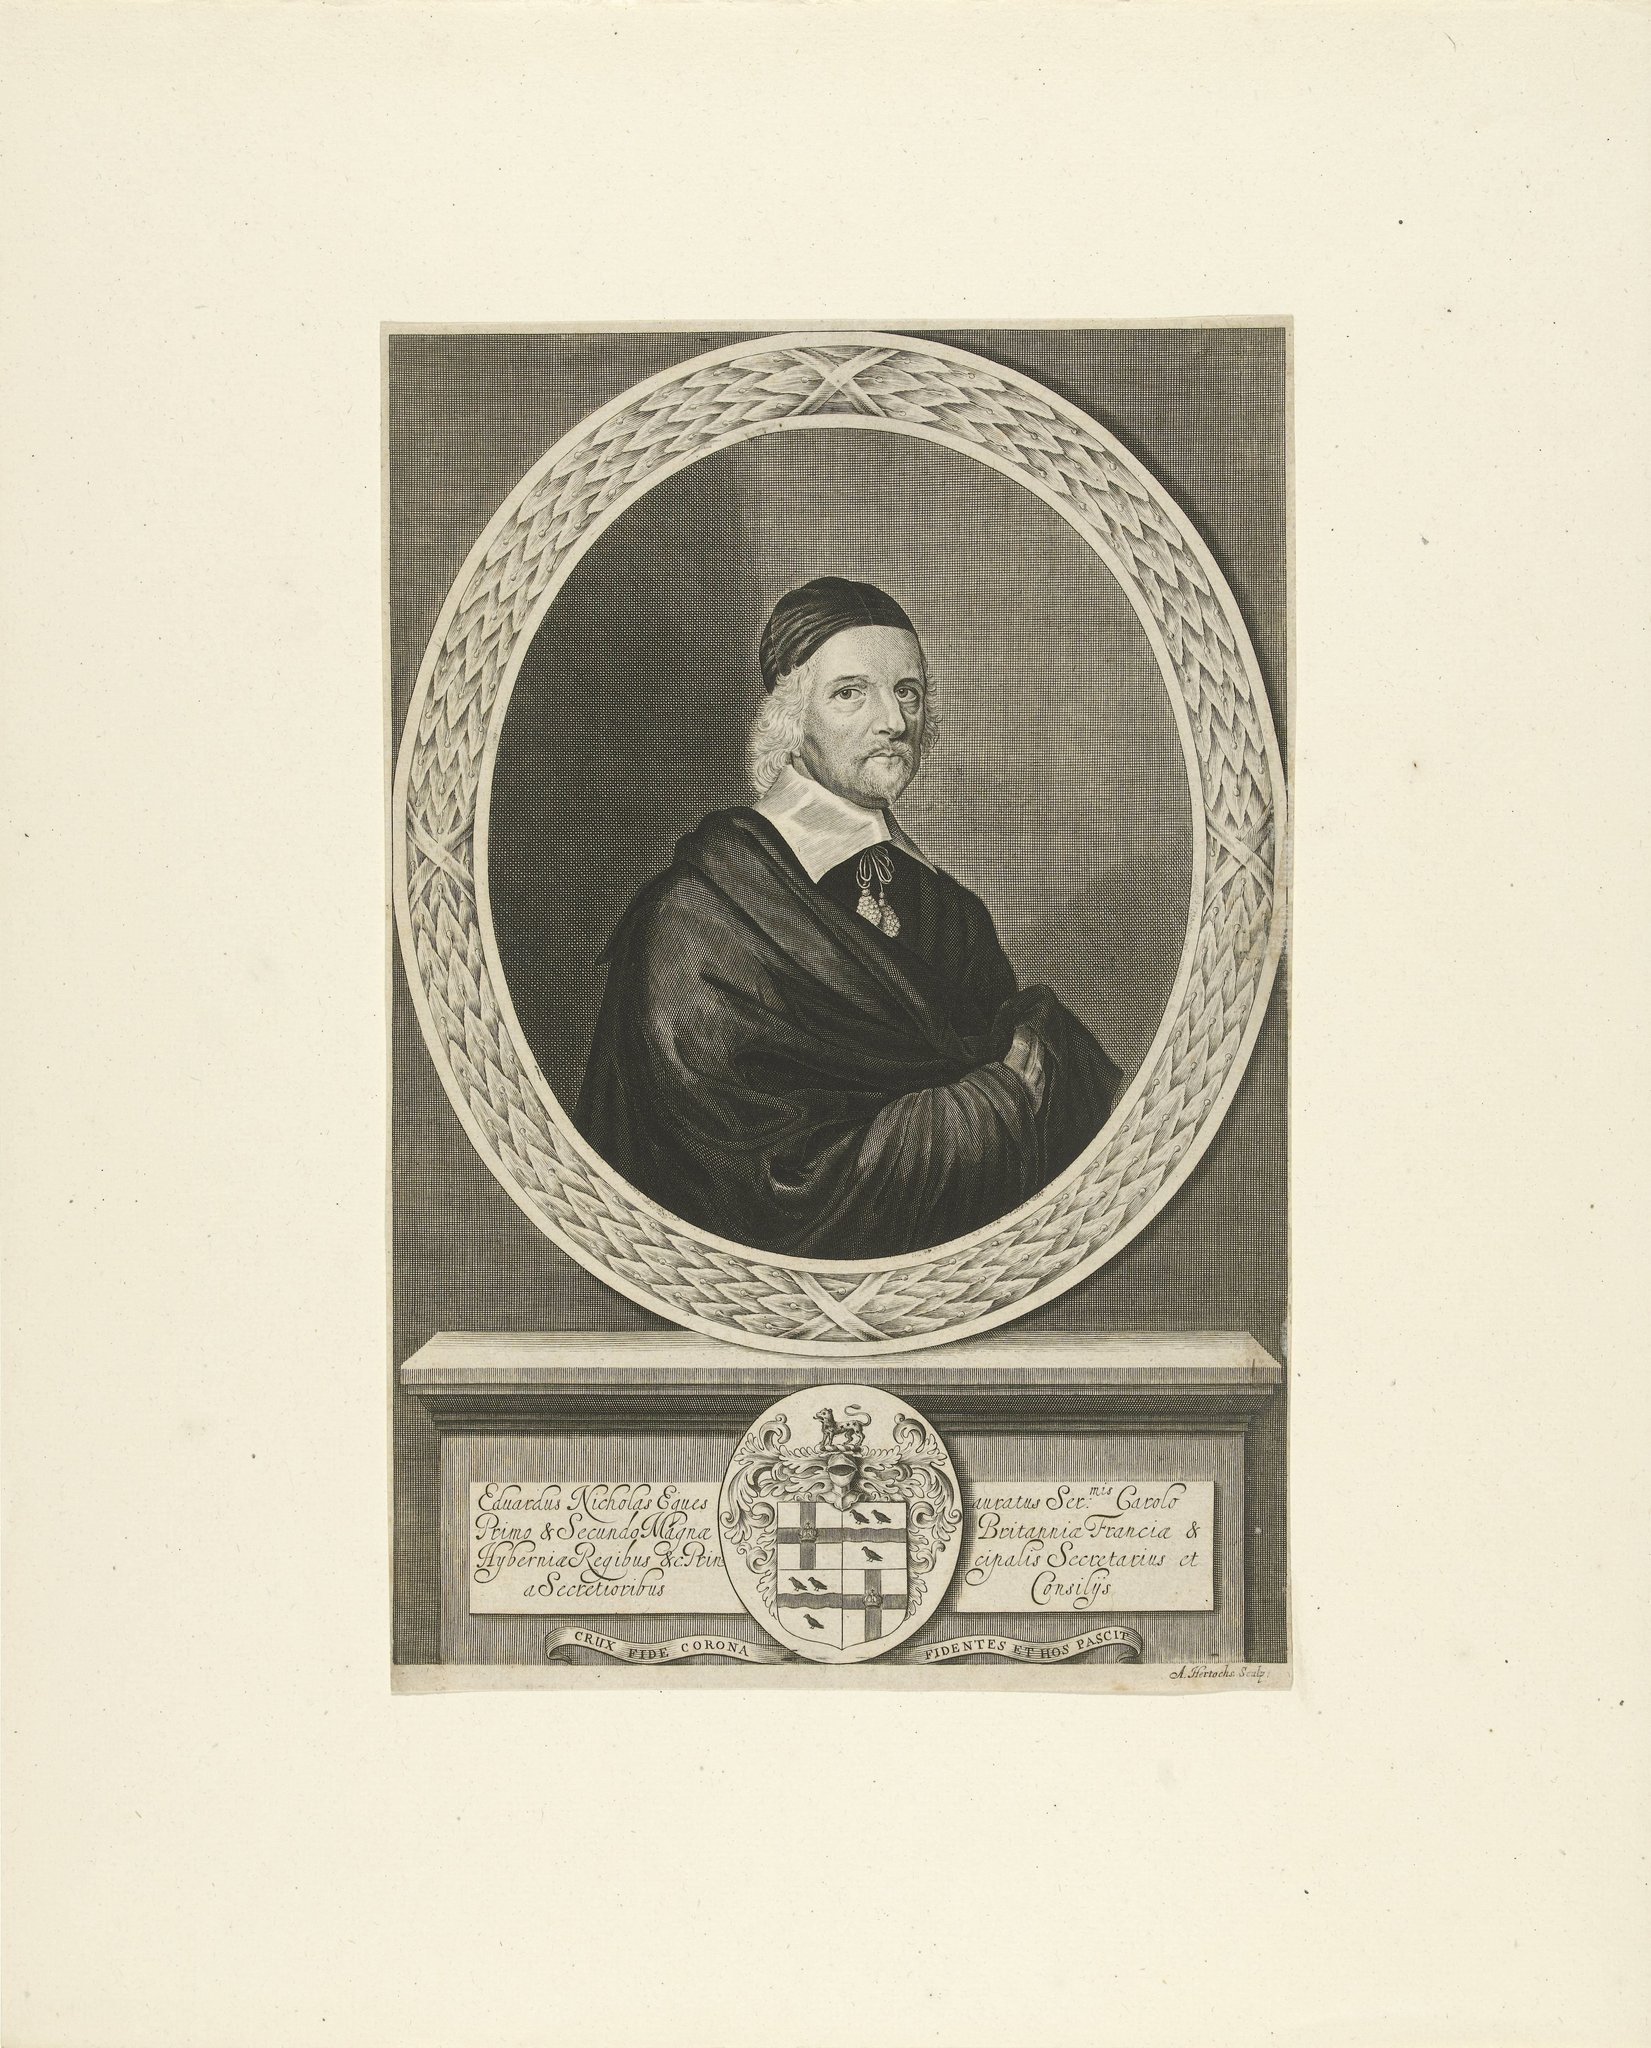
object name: print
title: Portret van Sir Edward Nicholas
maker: abraham hertochs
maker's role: print maker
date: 1626-1672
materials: paper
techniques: engraving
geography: england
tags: head-gear (with name)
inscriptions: collector's mark: Lugt 2228, collector's mark: Lugt 2760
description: Portret ten halven lijve naar rechts van Sir Edward Nicholas in een ovaal van een lauwerkrans op een piëdestal. Onder het portret een vierregelige tekst in het Latijn en zijn familiewapen met de spreuk: Crux fide corona fidentes et hos pascit.